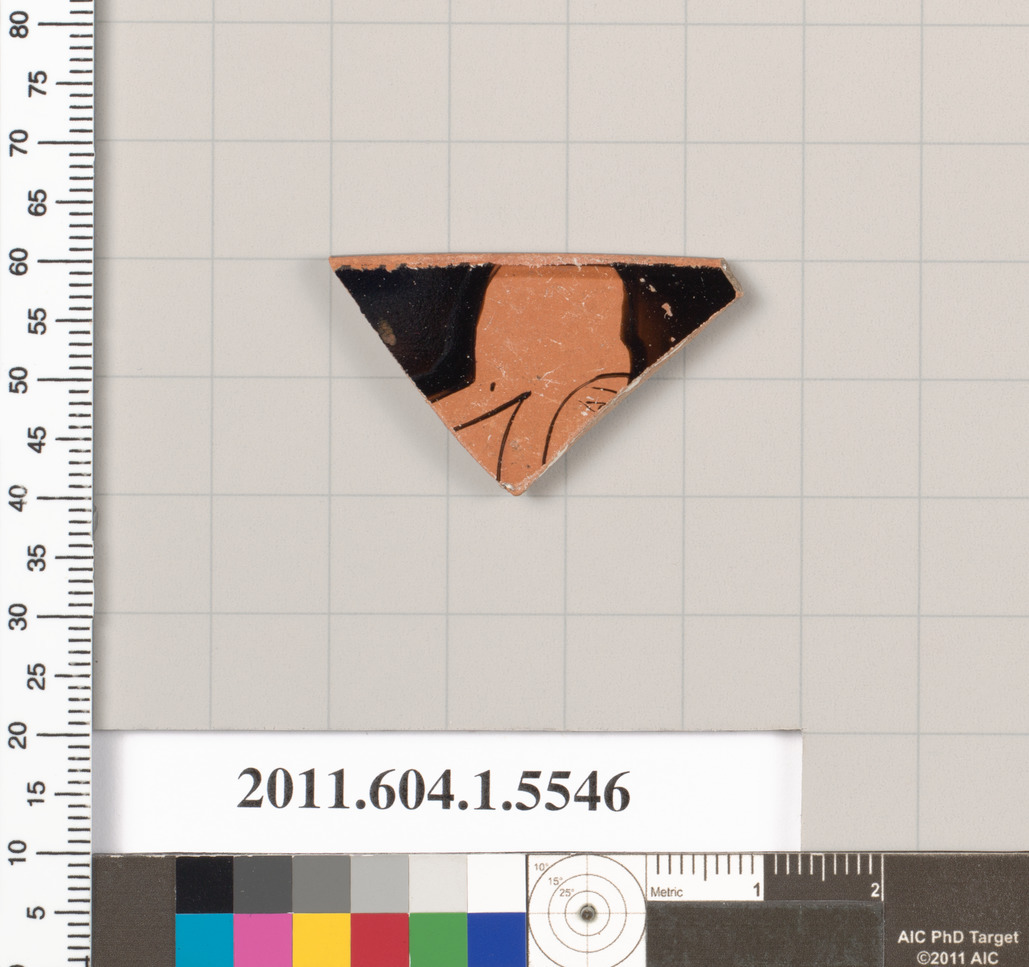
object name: kylix fragment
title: Terracotta rim fragment of a kylix (drinking cup)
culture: greek, attic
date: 500-480 BCE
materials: terracotta